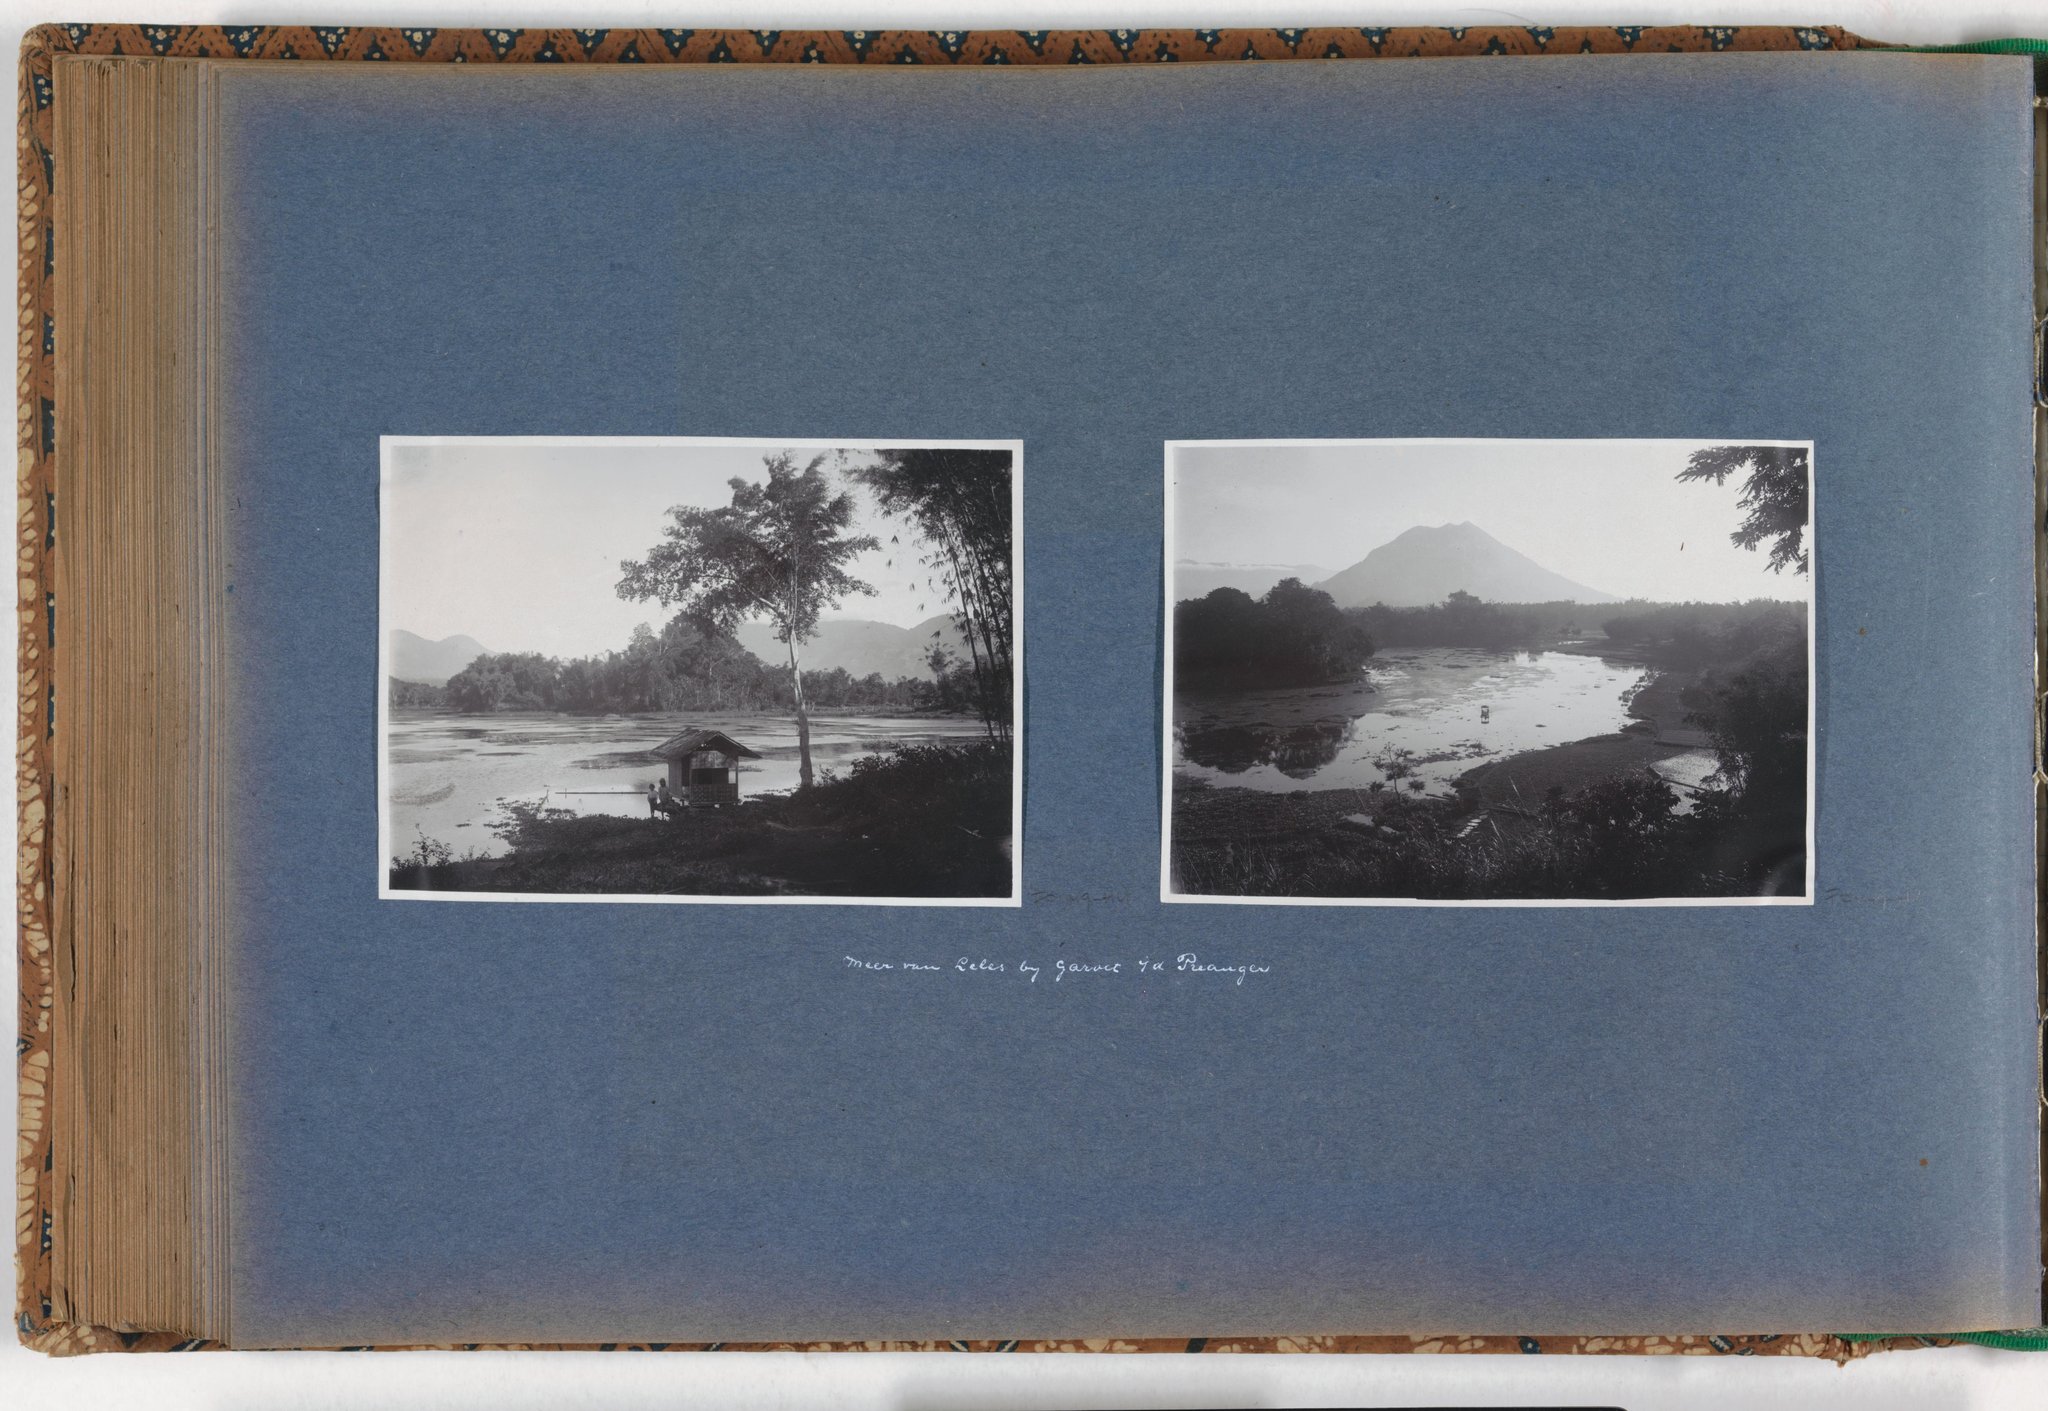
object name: photograph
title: Meer van Leles bij Garvet in Preanger, op de voorgrond kinderen bij een hut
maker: Anonymous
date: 1900-1920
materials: paper, photographic support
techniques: gelatin silver print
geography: preanger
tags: lake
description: Onderdeel van reisalbum met foto's van bedrijvigheid en bezienswaardigheden op Sumatra en Java en van de reis naar en van Nederlands-Indië.